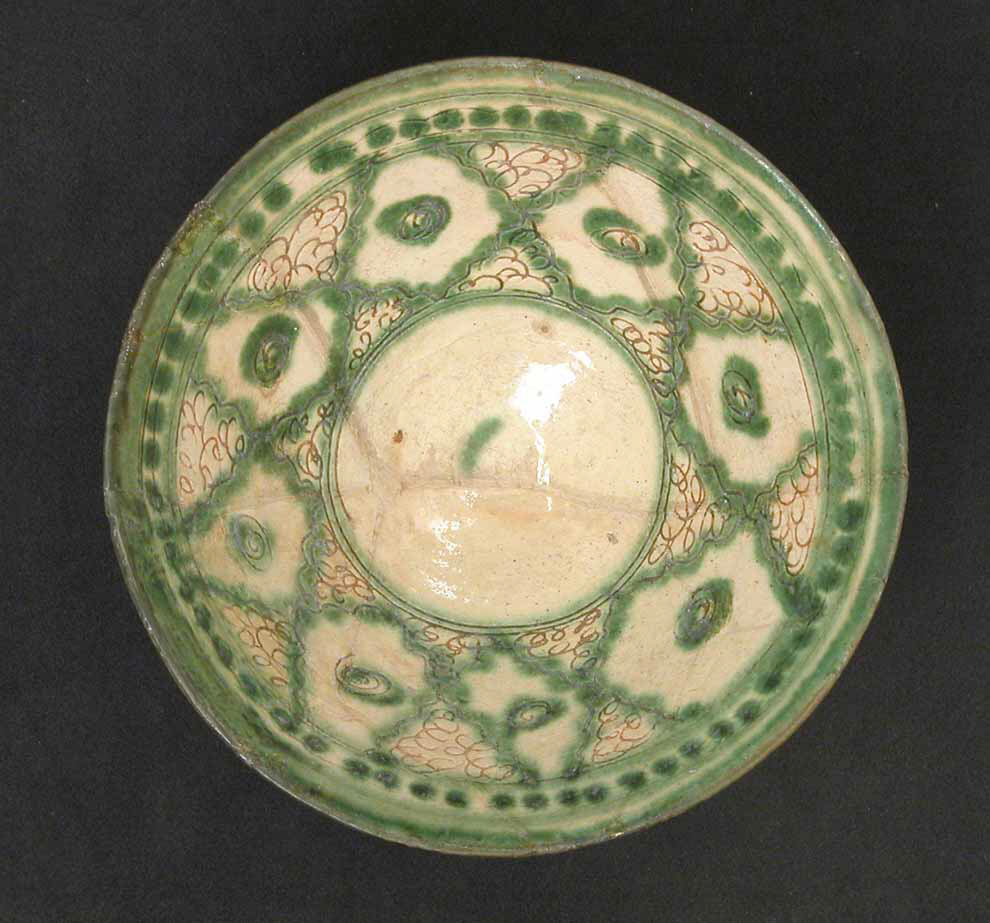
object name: bowl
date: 1101-1200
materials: earthenware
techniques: glazing, incising, painting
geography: iran